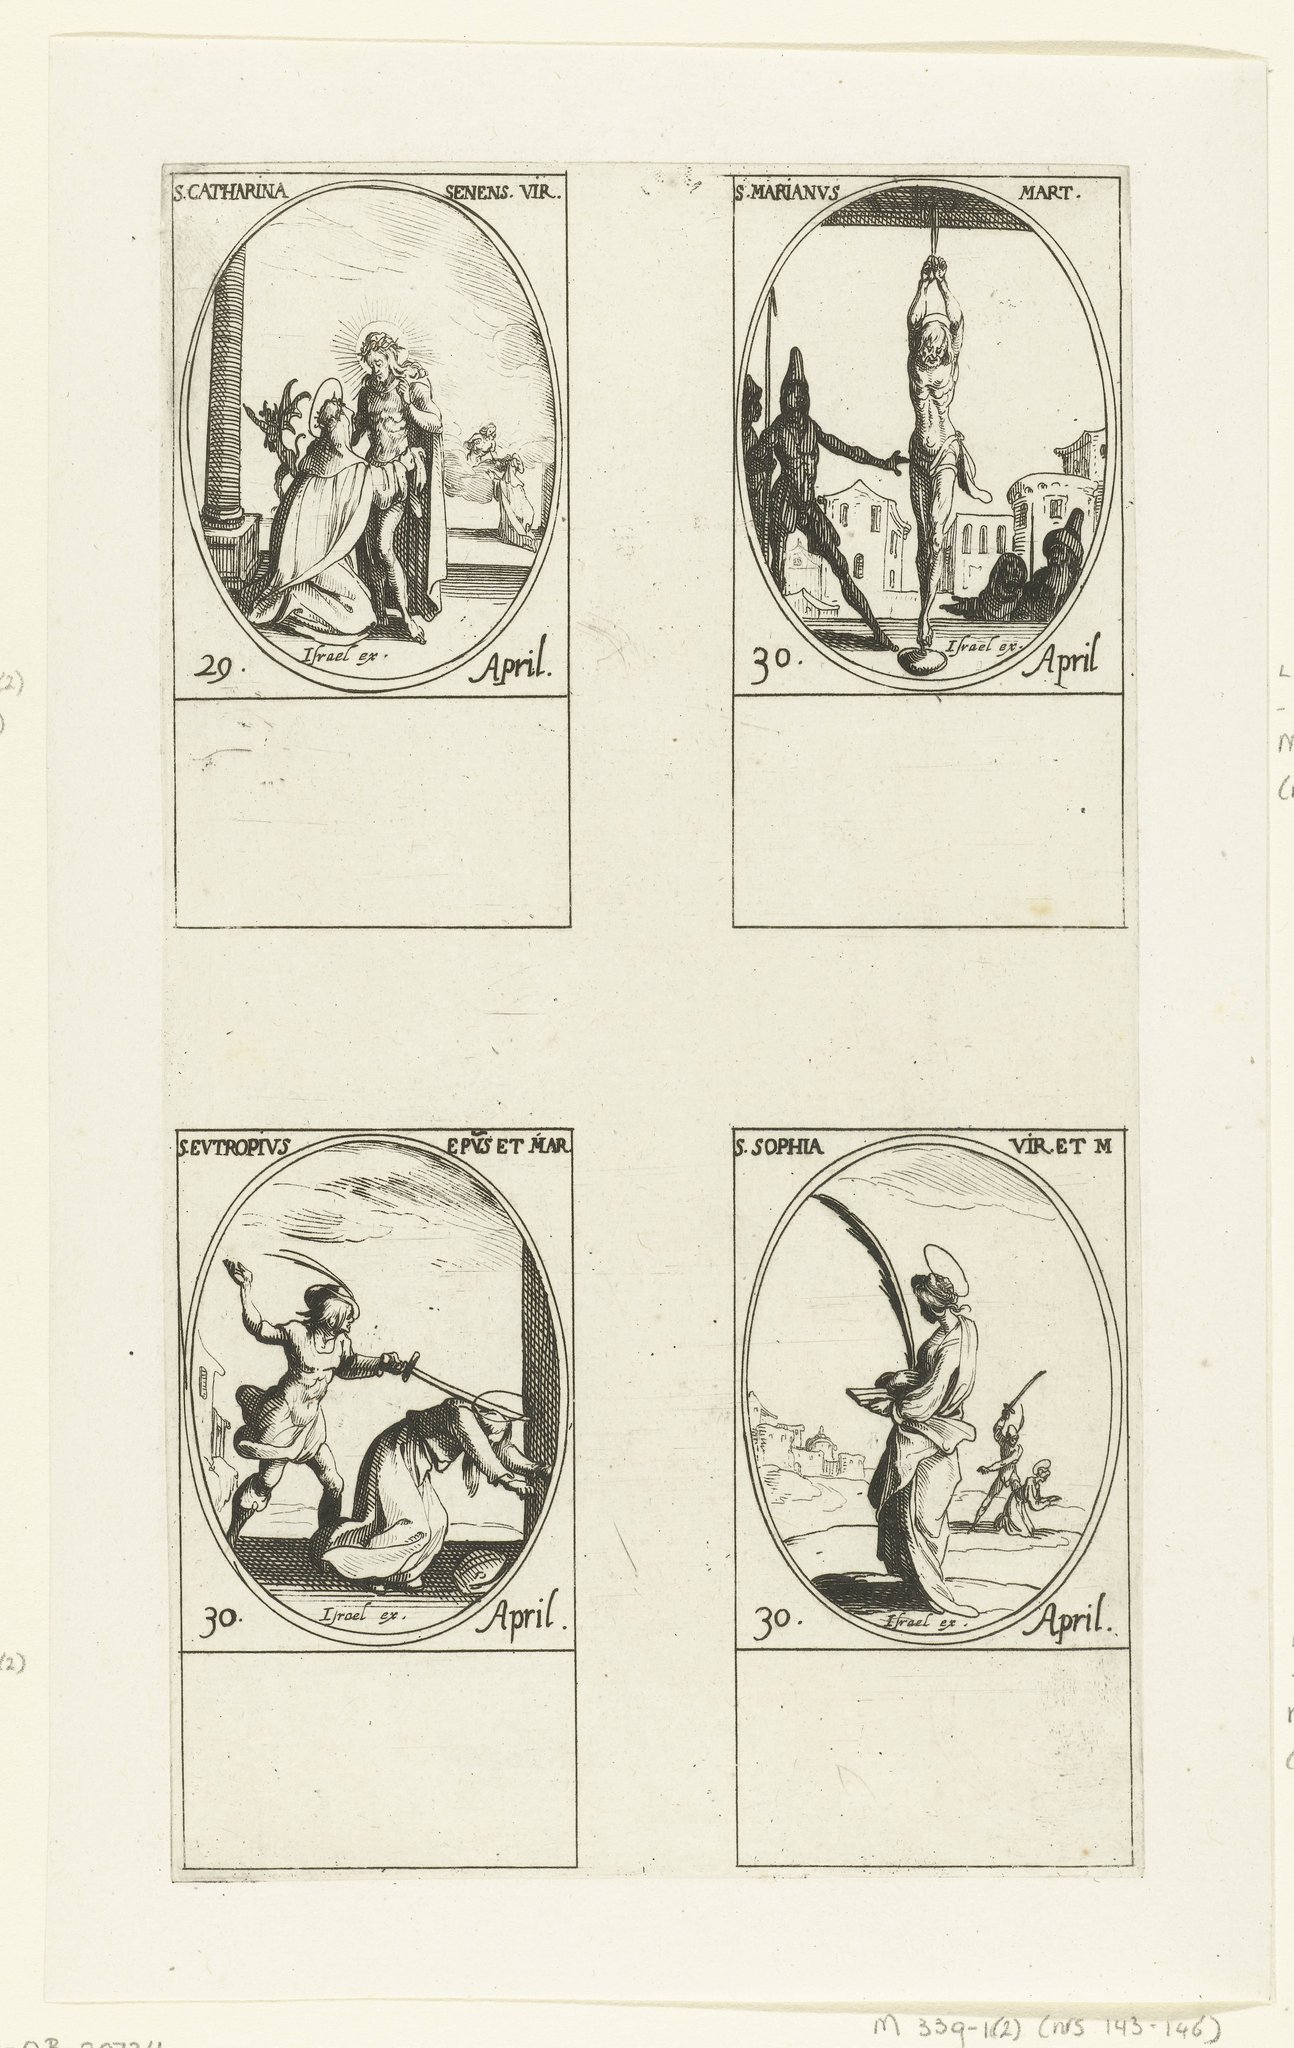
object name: print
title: Heilige Catharina van Siena, Heilige Marianus van Lambaesis, Heilige Eutropius van Saintes, Heilige Sophia (29-30 april)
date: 1632-1636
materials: paper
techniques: etching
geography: nancy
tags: male saints (with name), visions of st. catherine of siena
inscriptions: collector's mark: Lugt 240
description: Blad met vier ovale voorstellingen, elk met opschrift en datum in het Latijn: linksboven de Heilige Catharina van Siena die Christus ontmoet, rechtsboven de Heilige Marianus aan de handen opgehangen, linksonder de Heilige Eutropius door een man met een zwaard gedood, rechtsonder de Heilige Sophia met een palmtak. Deze prent is onderdeel van een serie prenten met voorstellingen van de heiligen en de christelijke feestdagen van het jaar. Er zijn steeds vier scènes van één plaat op één blad gedrukt. Inclusief bijbehorend titelblad en frontispice gaat het in totaal om 124 platen (490 voorstellingen). De drie platen met de laatste 12 scènes (de veranderlijke christelijke feestdagen) zijn in de derde staat versneden tot 12 kleine plaatjes, en met een apart titelblad uitgegeven.